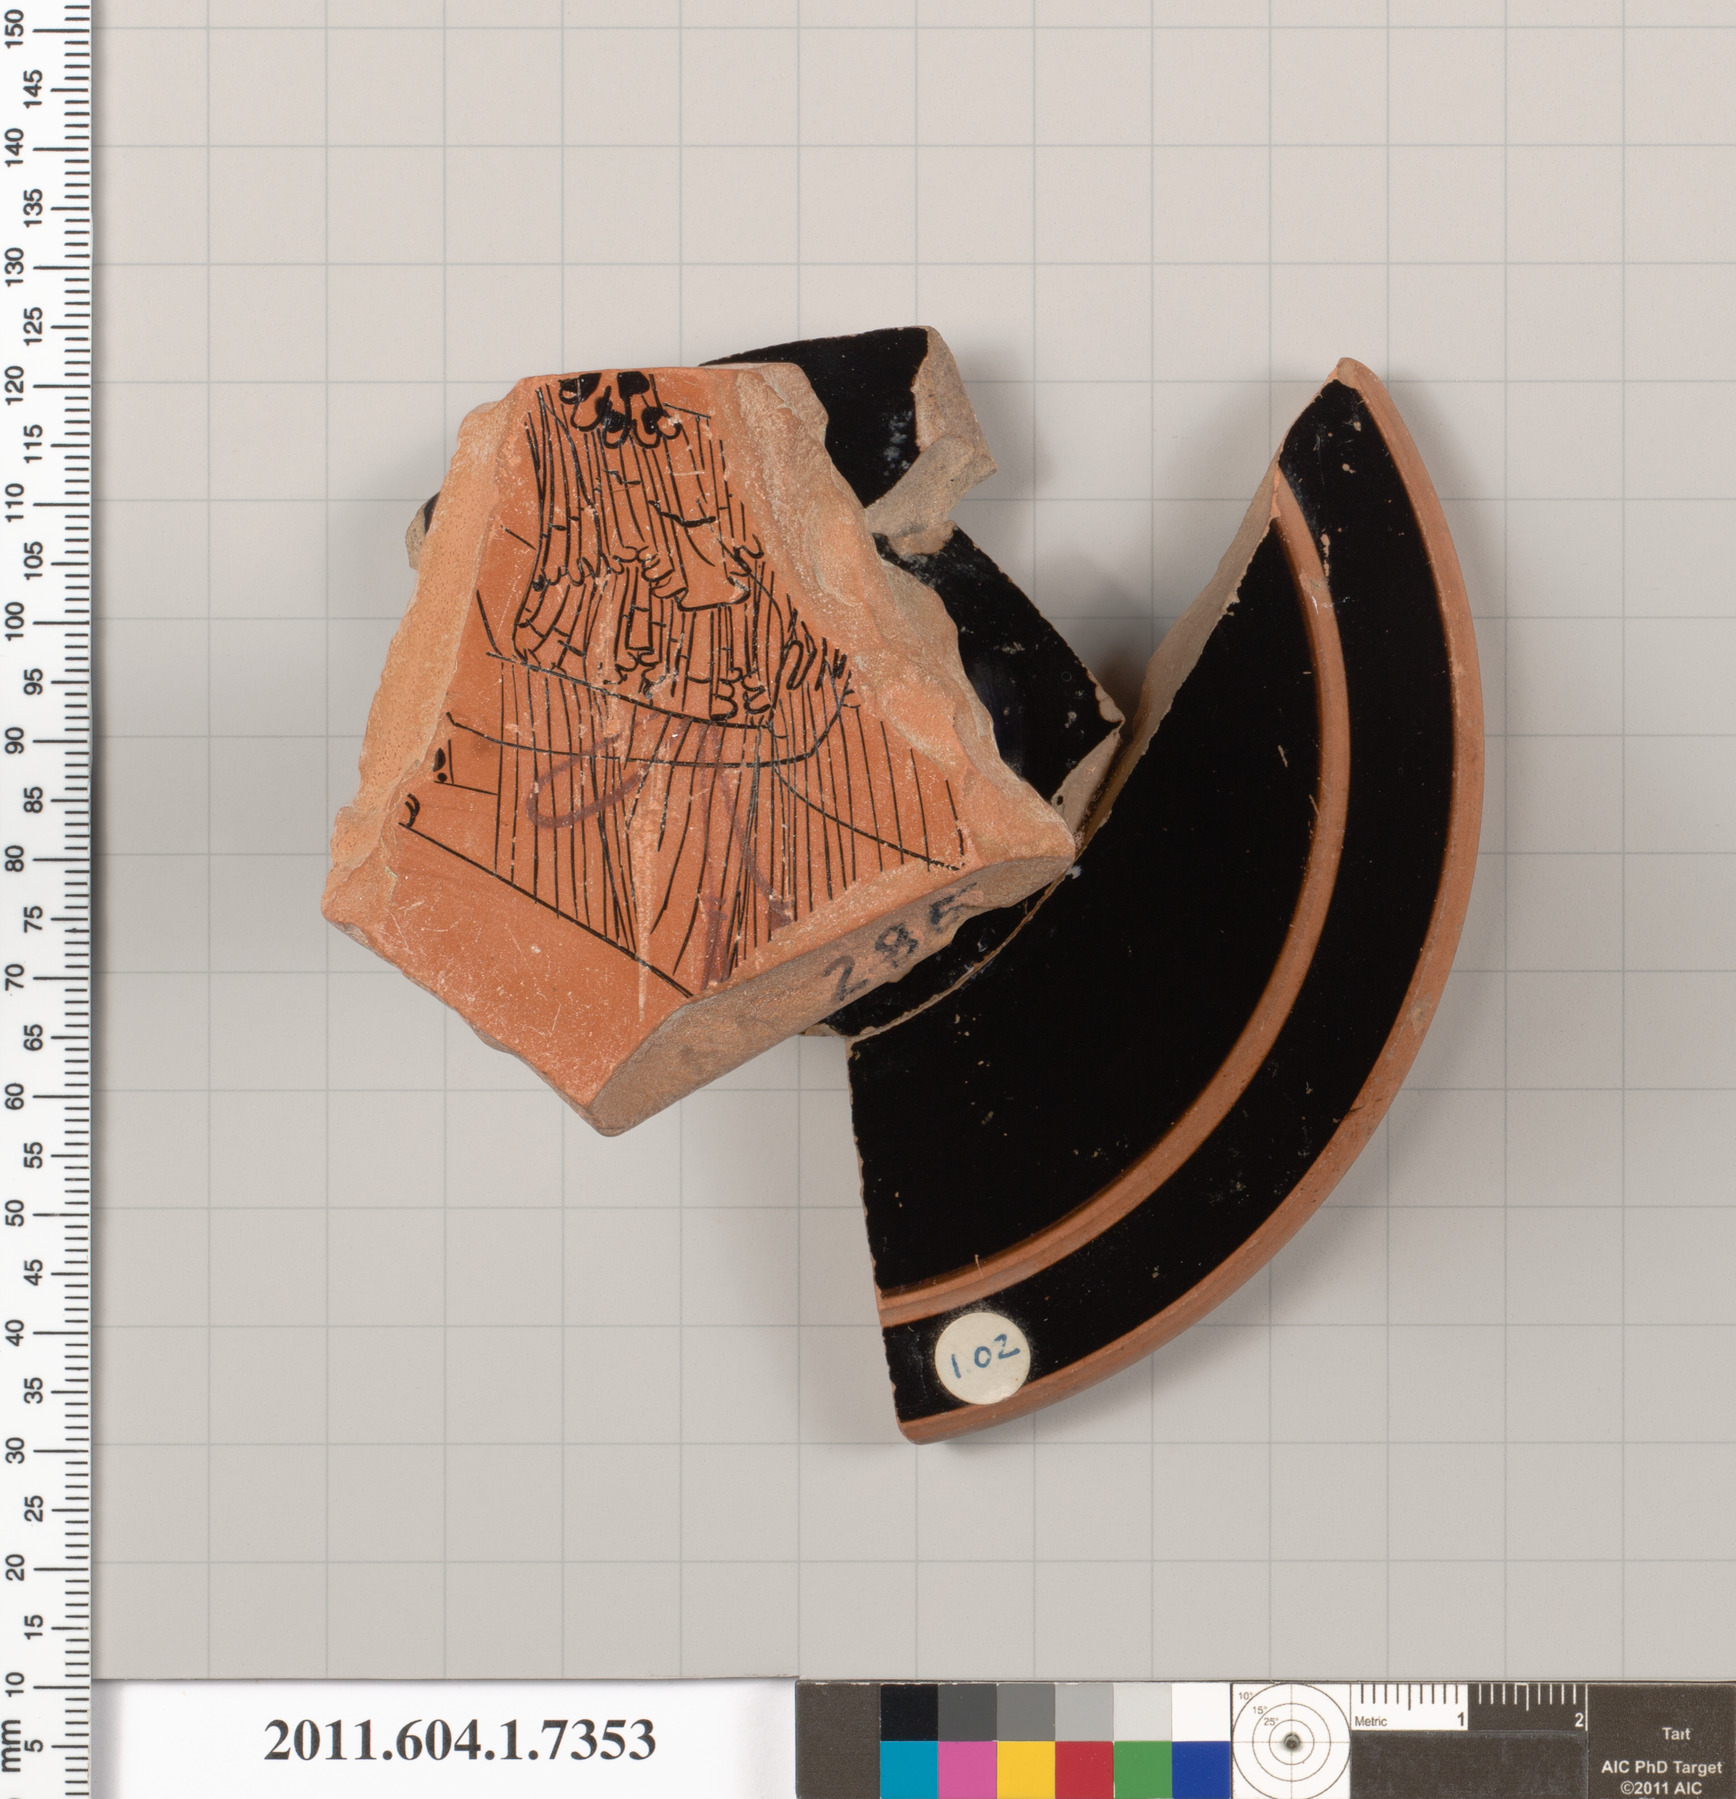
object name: kylix fragment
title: Terracotta fragment of a kylix (drinking cup)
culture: greek, attic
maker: makron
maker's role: artist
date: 500-480 BCE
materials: terracotta